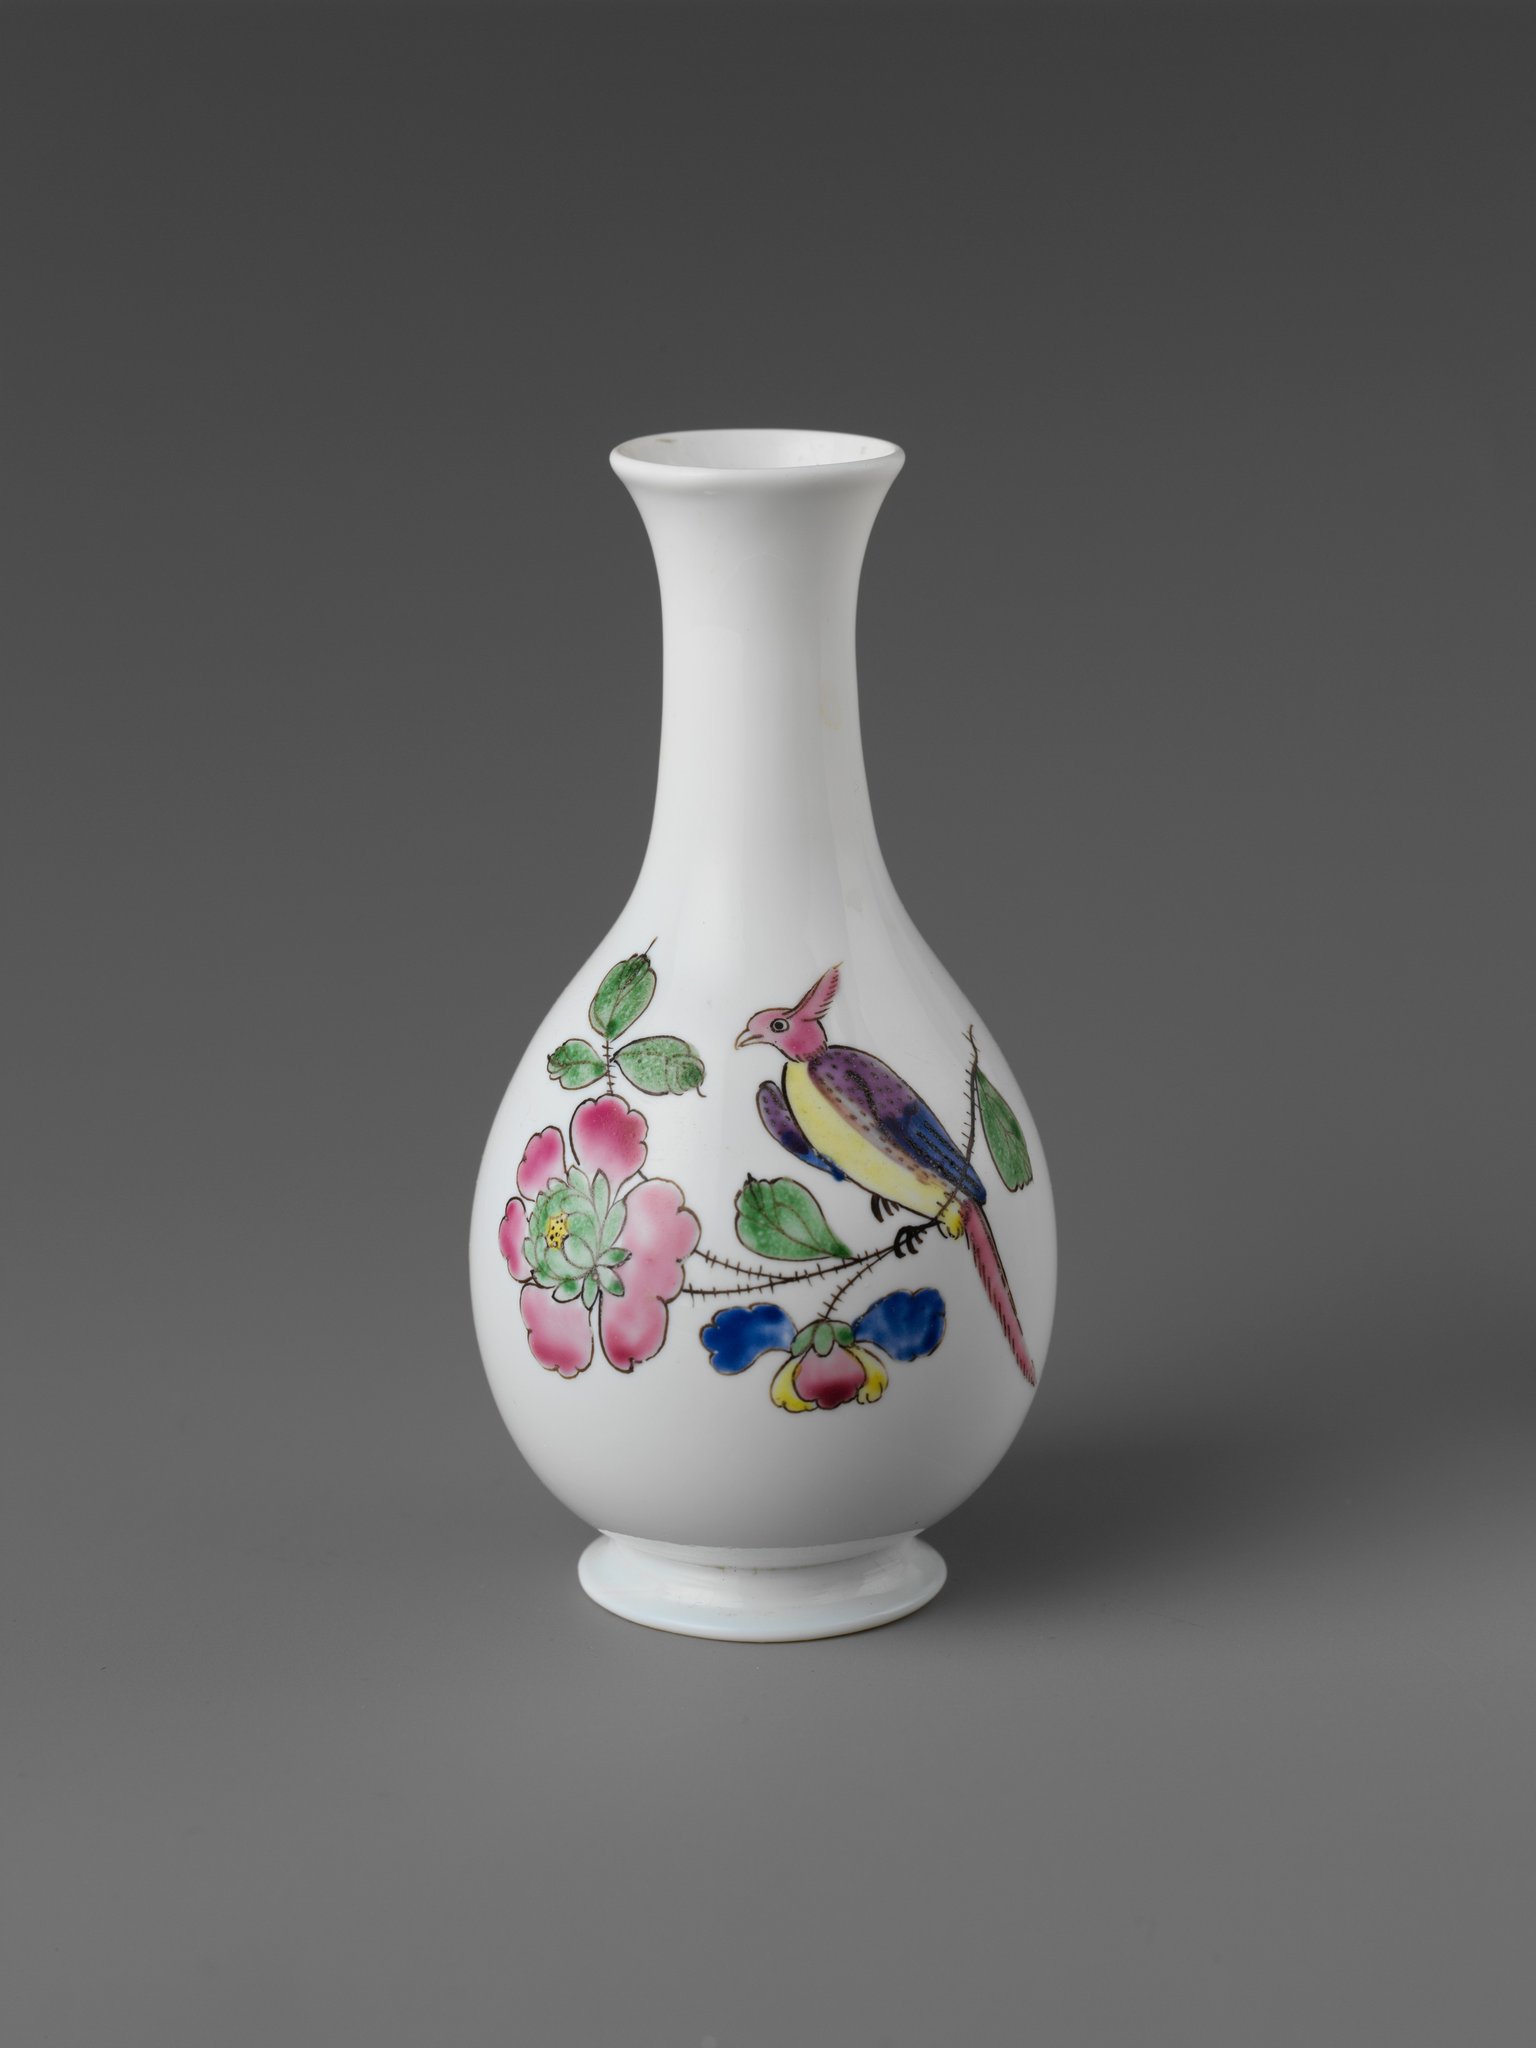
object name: bottle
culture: british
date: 1760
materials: enamel, glass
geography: england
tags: birds,flowers